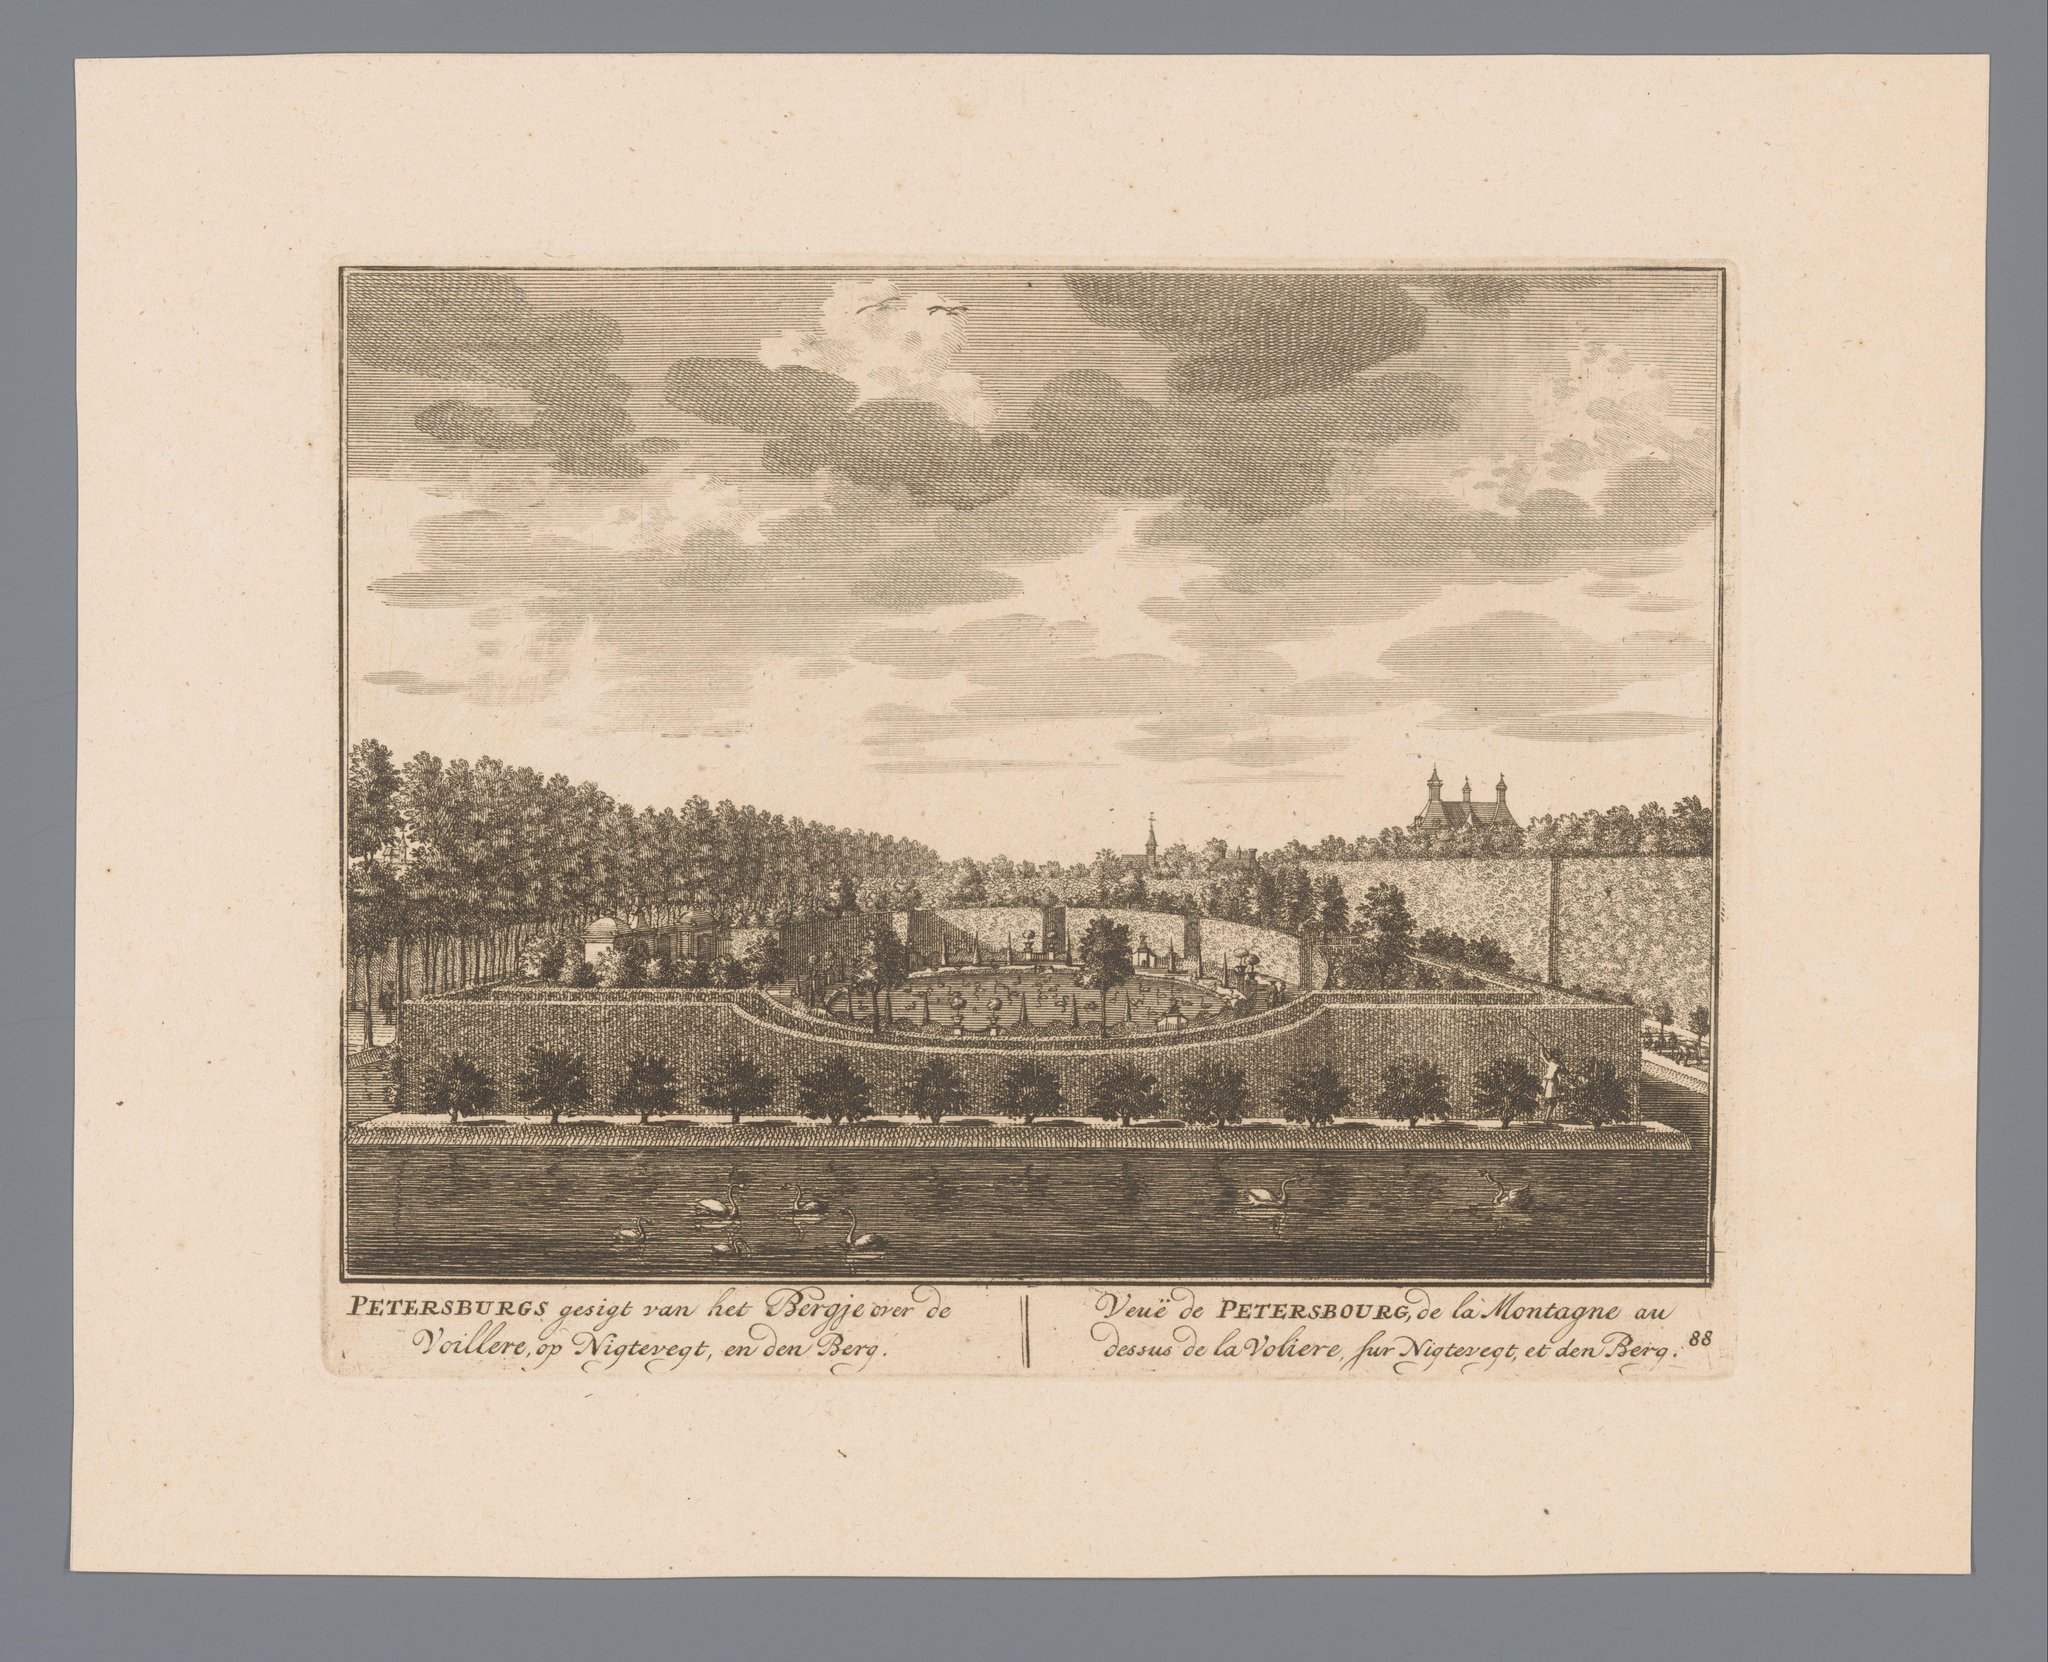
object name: print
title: Gezicht op de volière in de tuin van huis Petersburg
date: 1719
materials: paper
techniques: etching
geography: amsterdam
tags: birds in a large cage, aviary, french or architectonic garden; formal garden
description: Prent uit: De zegepraalende Vecht, vertoonende verscheidene gesichten van lustplaatsen, heeren huysen en dorpen, beginnende van Uitrecht en met Muyden besluytende. Amsterdam: Wed. Nicolaes Visscher, 1719.